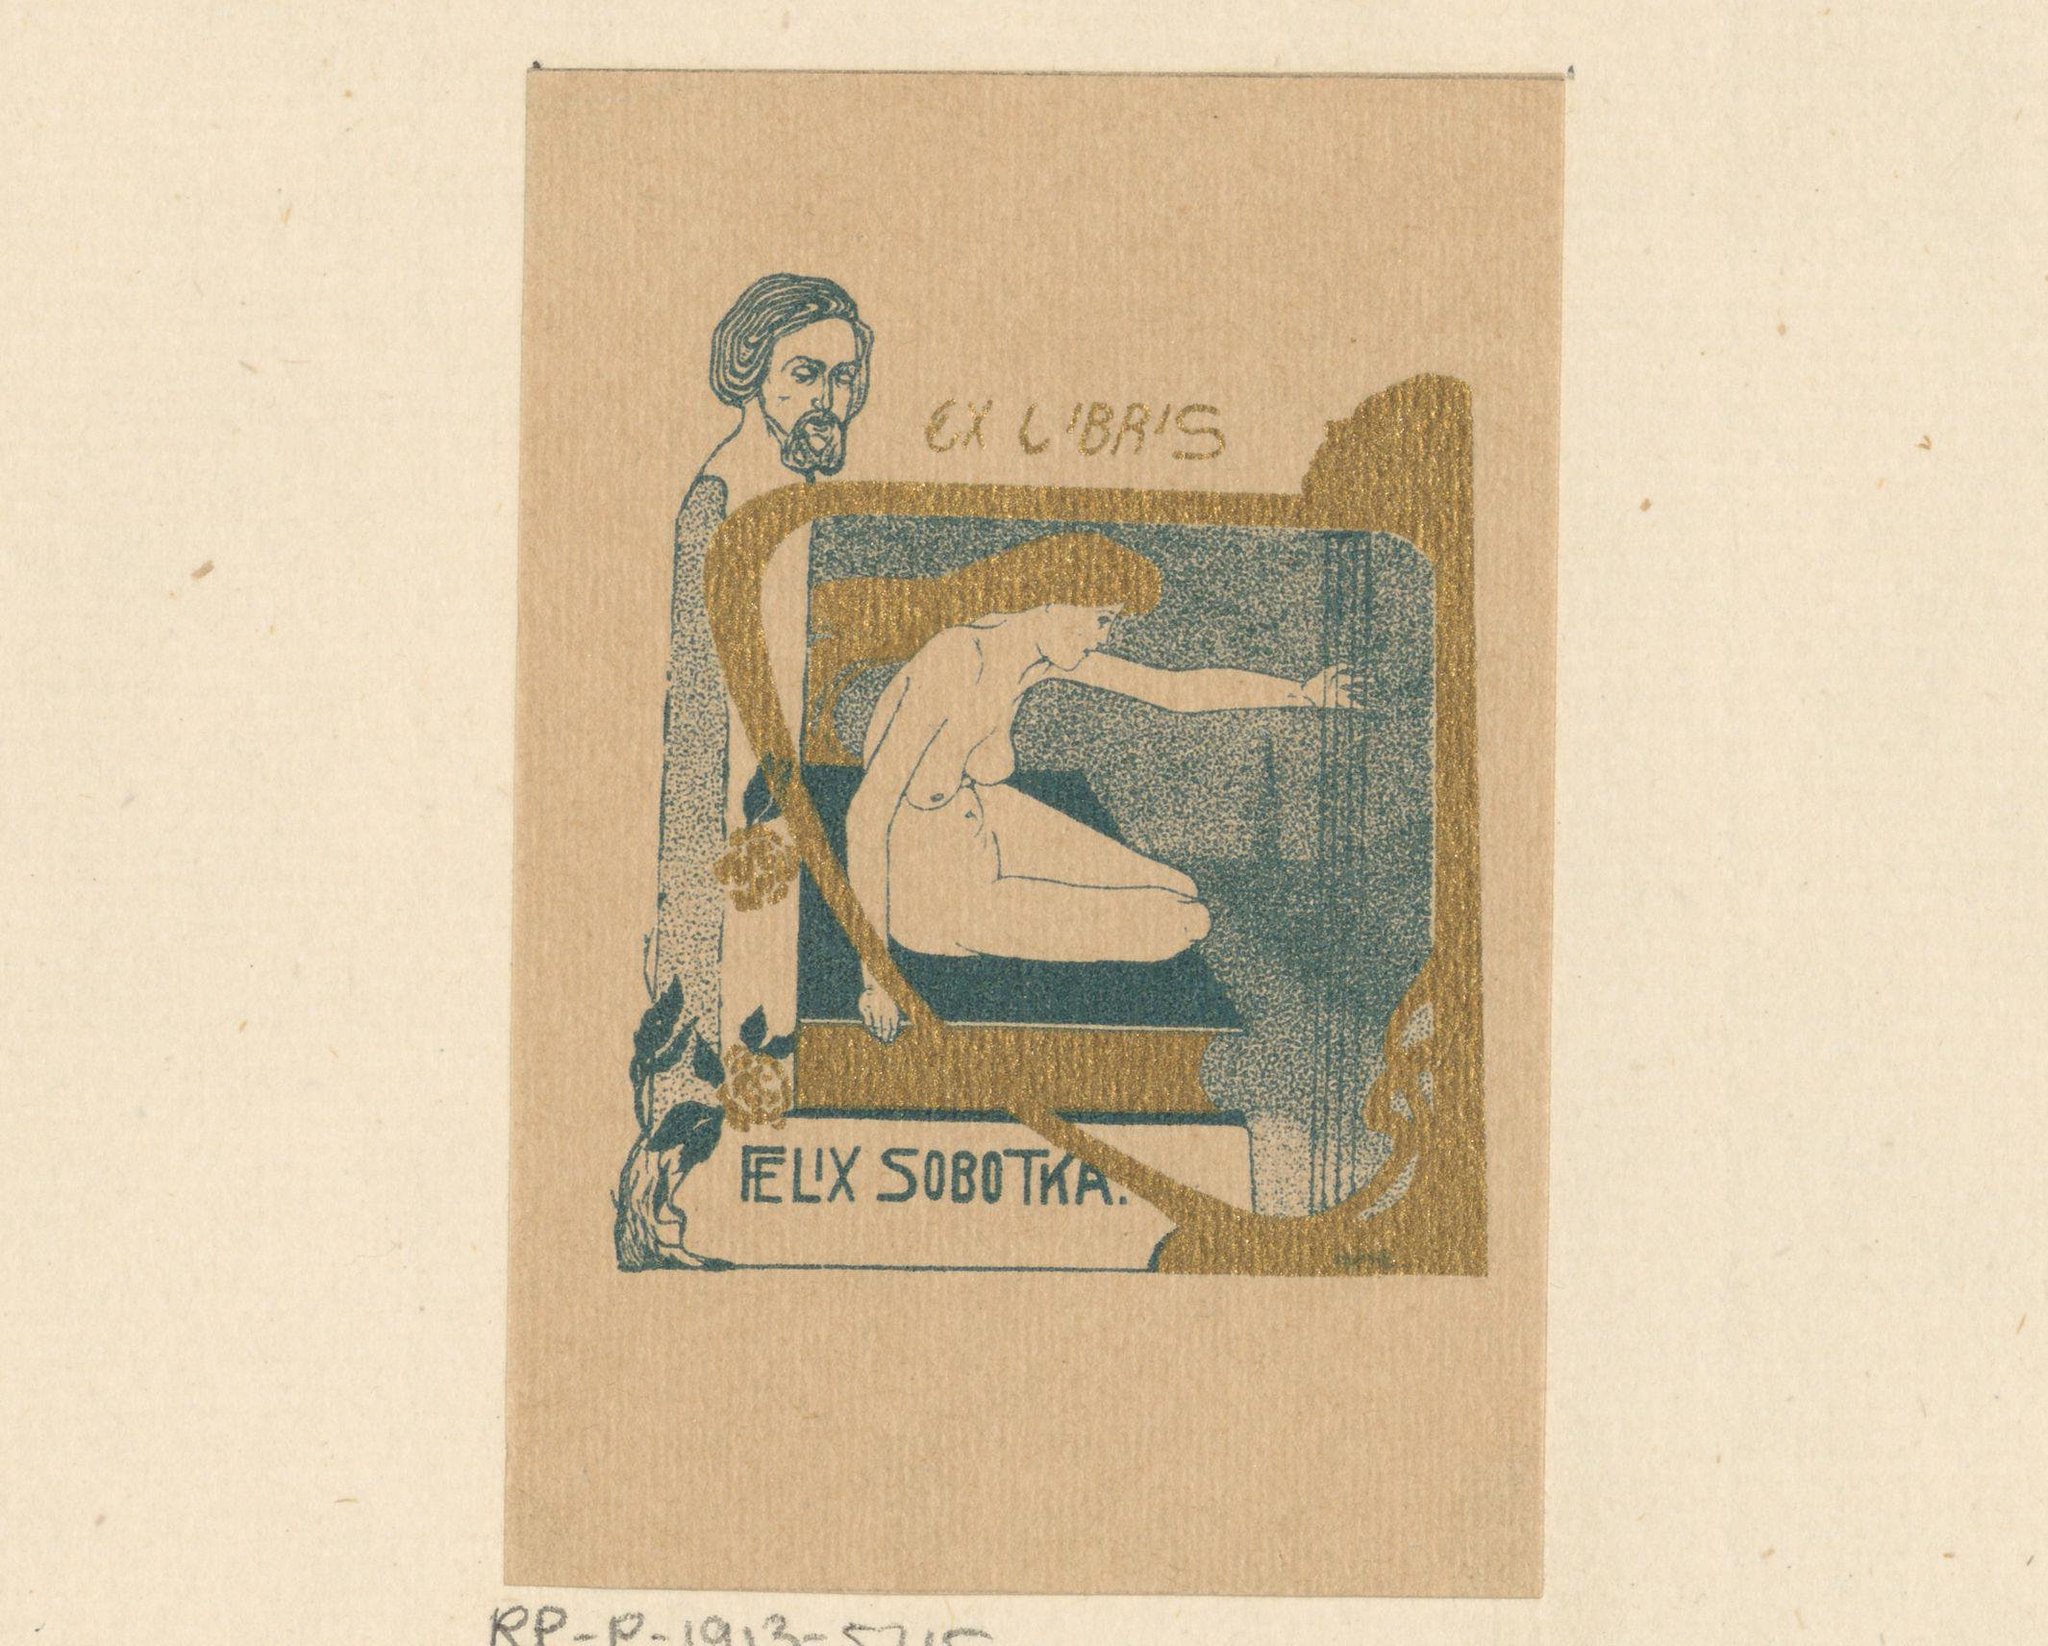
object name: bookplate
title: Ex libris van Felix Sobotka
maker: max horb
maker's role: painter, print maker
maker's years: 1882-1907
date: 1892-1907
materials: paper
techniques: lithograph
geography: czech republic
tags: herms (garden ornaments), woman (showing herself) undressed, quasi-nude, harp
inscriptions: collector's mark: Lugt 2233, collector's mark: Lugt 2760